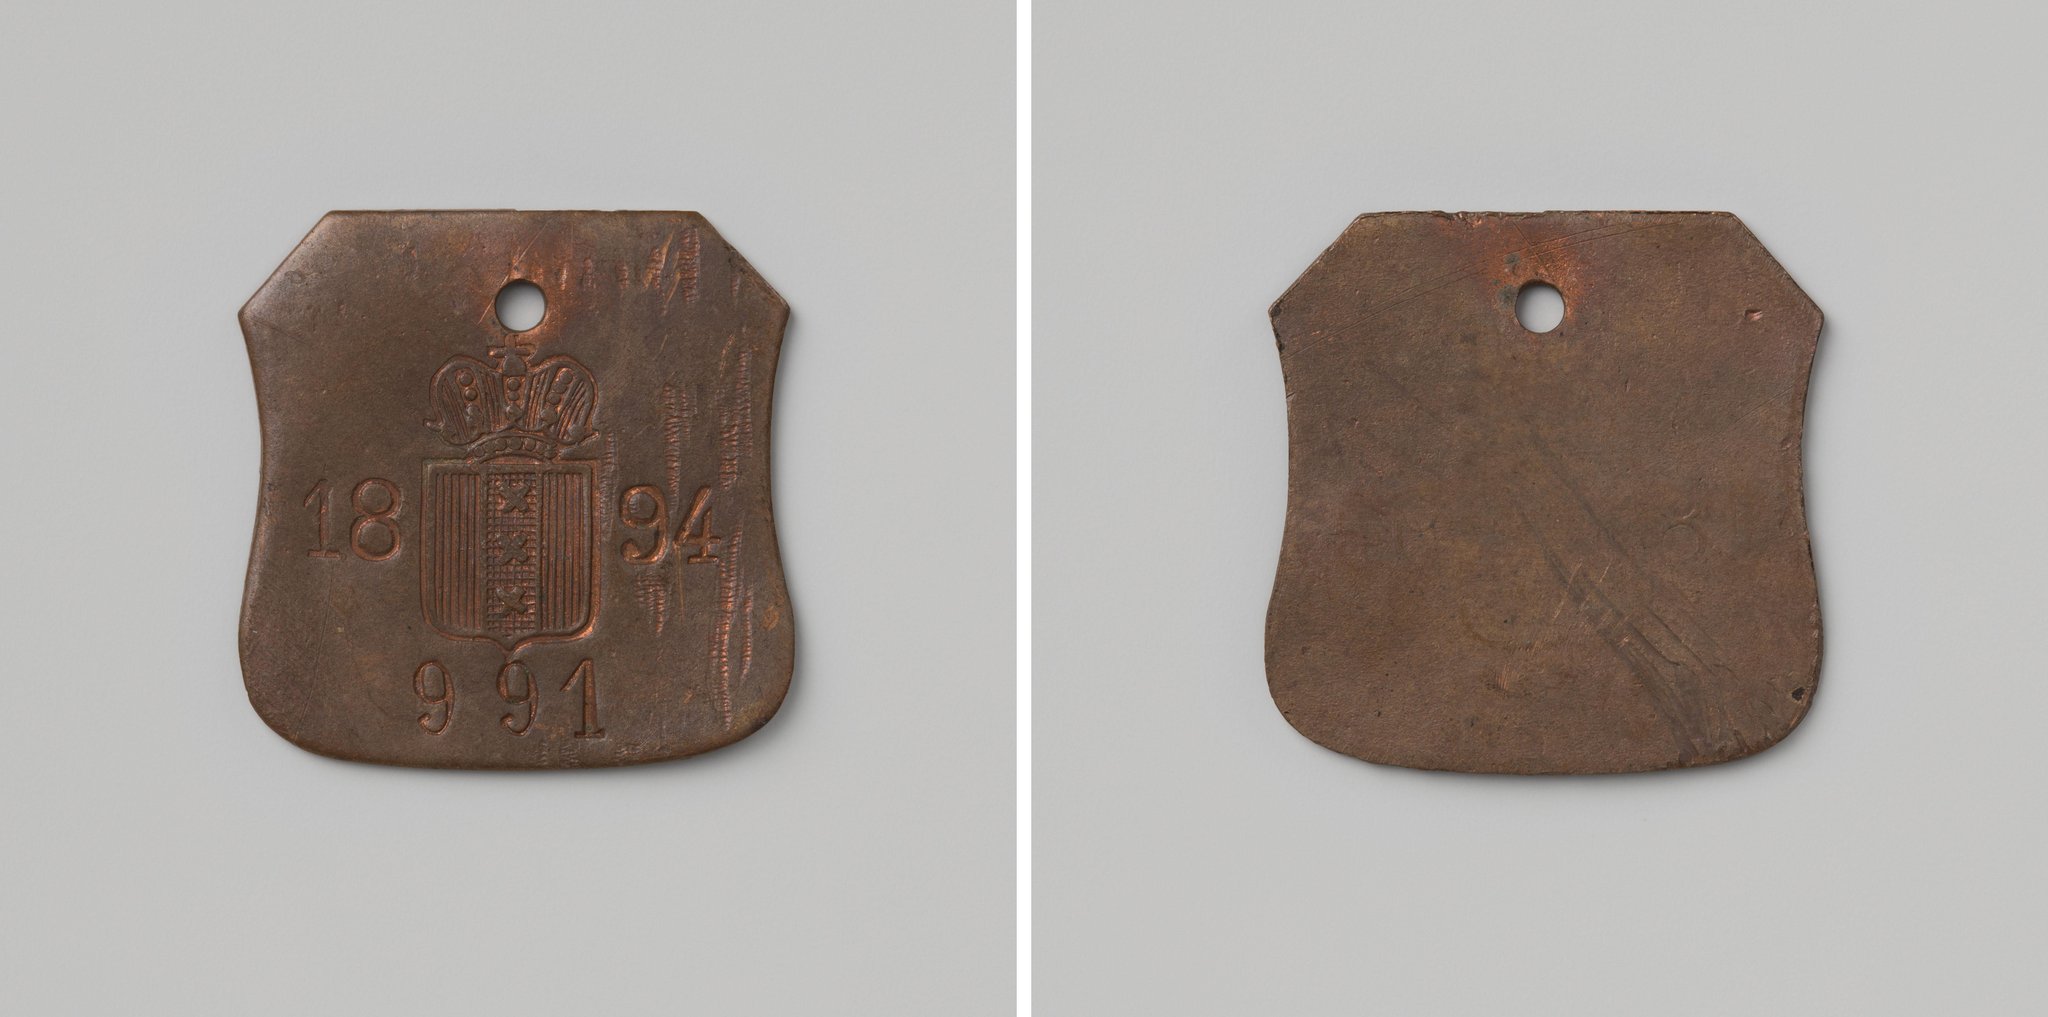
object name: tax token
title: Stad Amsterdam, loodje met no. 991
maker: Anonymous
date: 1894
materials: copper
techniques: striking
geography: amsterdam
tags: amsterdam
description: eenzijdig, ruitvormig loodje met holle zijden, aan bovenzijde afgeschuinde hoeken en gat, en aan onderzijde afgeronde hoeken. Voorzijde: gekroond wapenschild tussen jaartal boven cijfer 991. Keerzijde: blanco